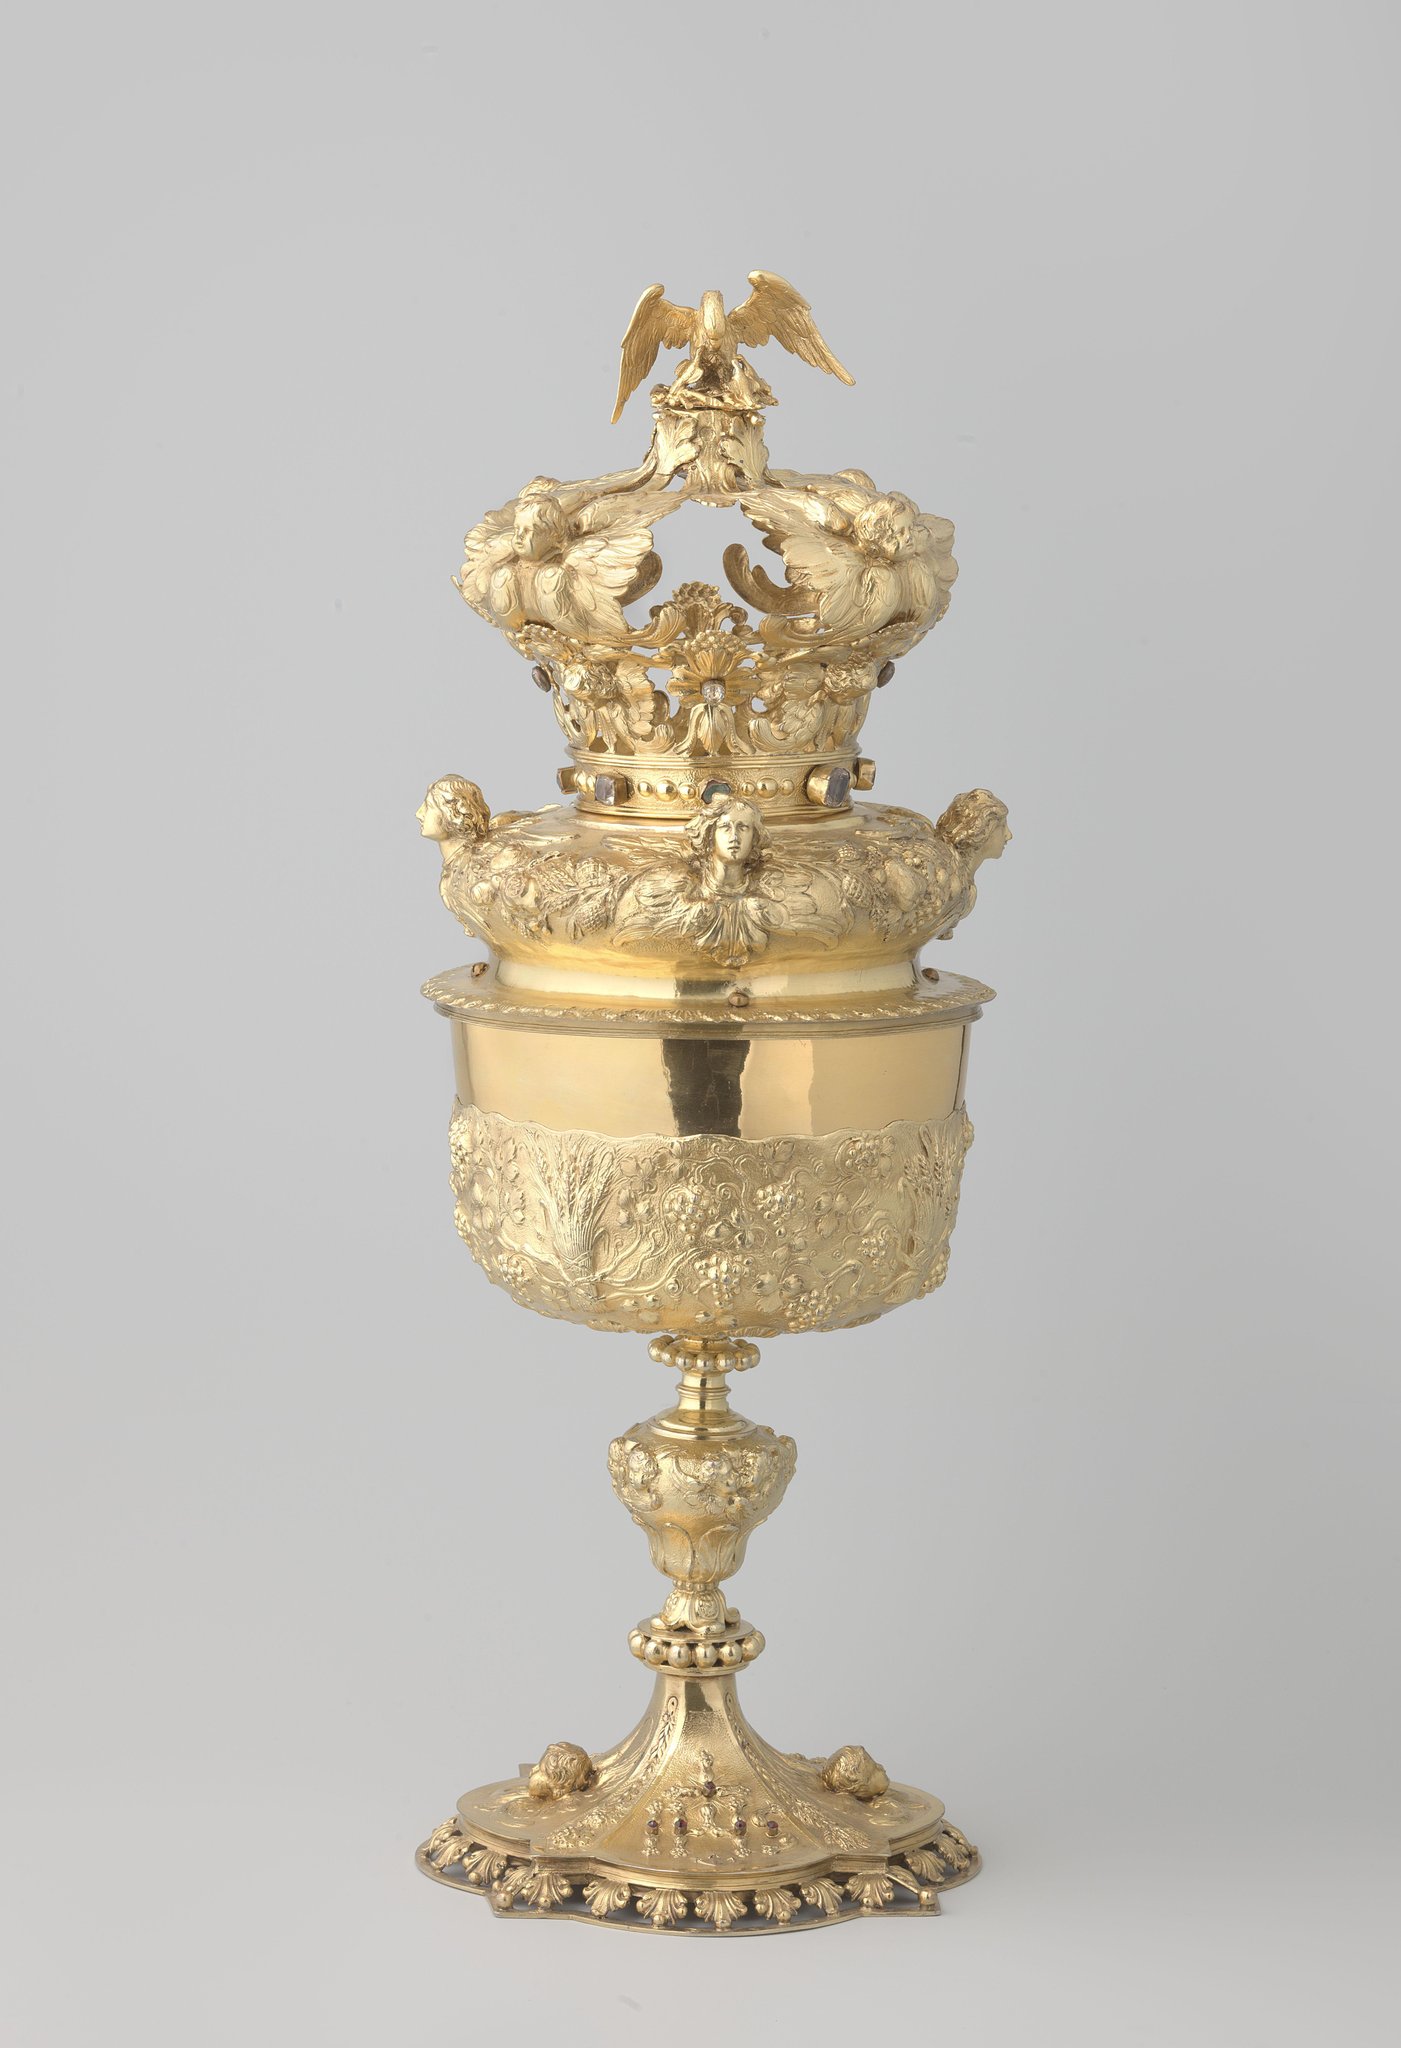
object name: ciborium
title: Ciborie van verguld zilver met jaartal 1652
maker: jean moermans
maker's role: goldsmith, silversmith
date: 1655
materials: silver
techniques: gilding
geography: antwerp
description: Ciborie van verguld zilver. Op de voet die een opengewerkte rand met bladeren heeft, zijn twee engelenkopjes en de monogrammen van Christus en Maria aangebracht. Op de nodus zitten engelenkopjes met zuil, anker en kelk. De cuppa is versierd in reliëf met druivetrossen aan ranken en met arenbundels. De overkragende deksel is versierd met vier engelenkopjes met vleugels in zeer hoog reliëf, waartussen vruchtenguirlandes. De deksel wordt bekroond door een hoge open kroon met cherubkopjes met grote vleugels en bovenop een pelikaan met jongen op een nest. Op de kop van de pelikaan een noet bijbehorend kruisje. Tussen voet en nodus bevindt zich een pen met schroefdraad, die bevestigd is in een munt of penning met het jaartal 1652. De ciborie is gemerkt met een gekroonde hand (Antwerpen), jaarletters Y=1655 en een meesterteken waarbij in een driehoek de letters I en M onder elkaar staan. Dit is het teken voor Jan Moermans (Ros.3 5131) Onder de voetring ingeslagen de letters S.J. In de kroon ontbreken drie moeren.